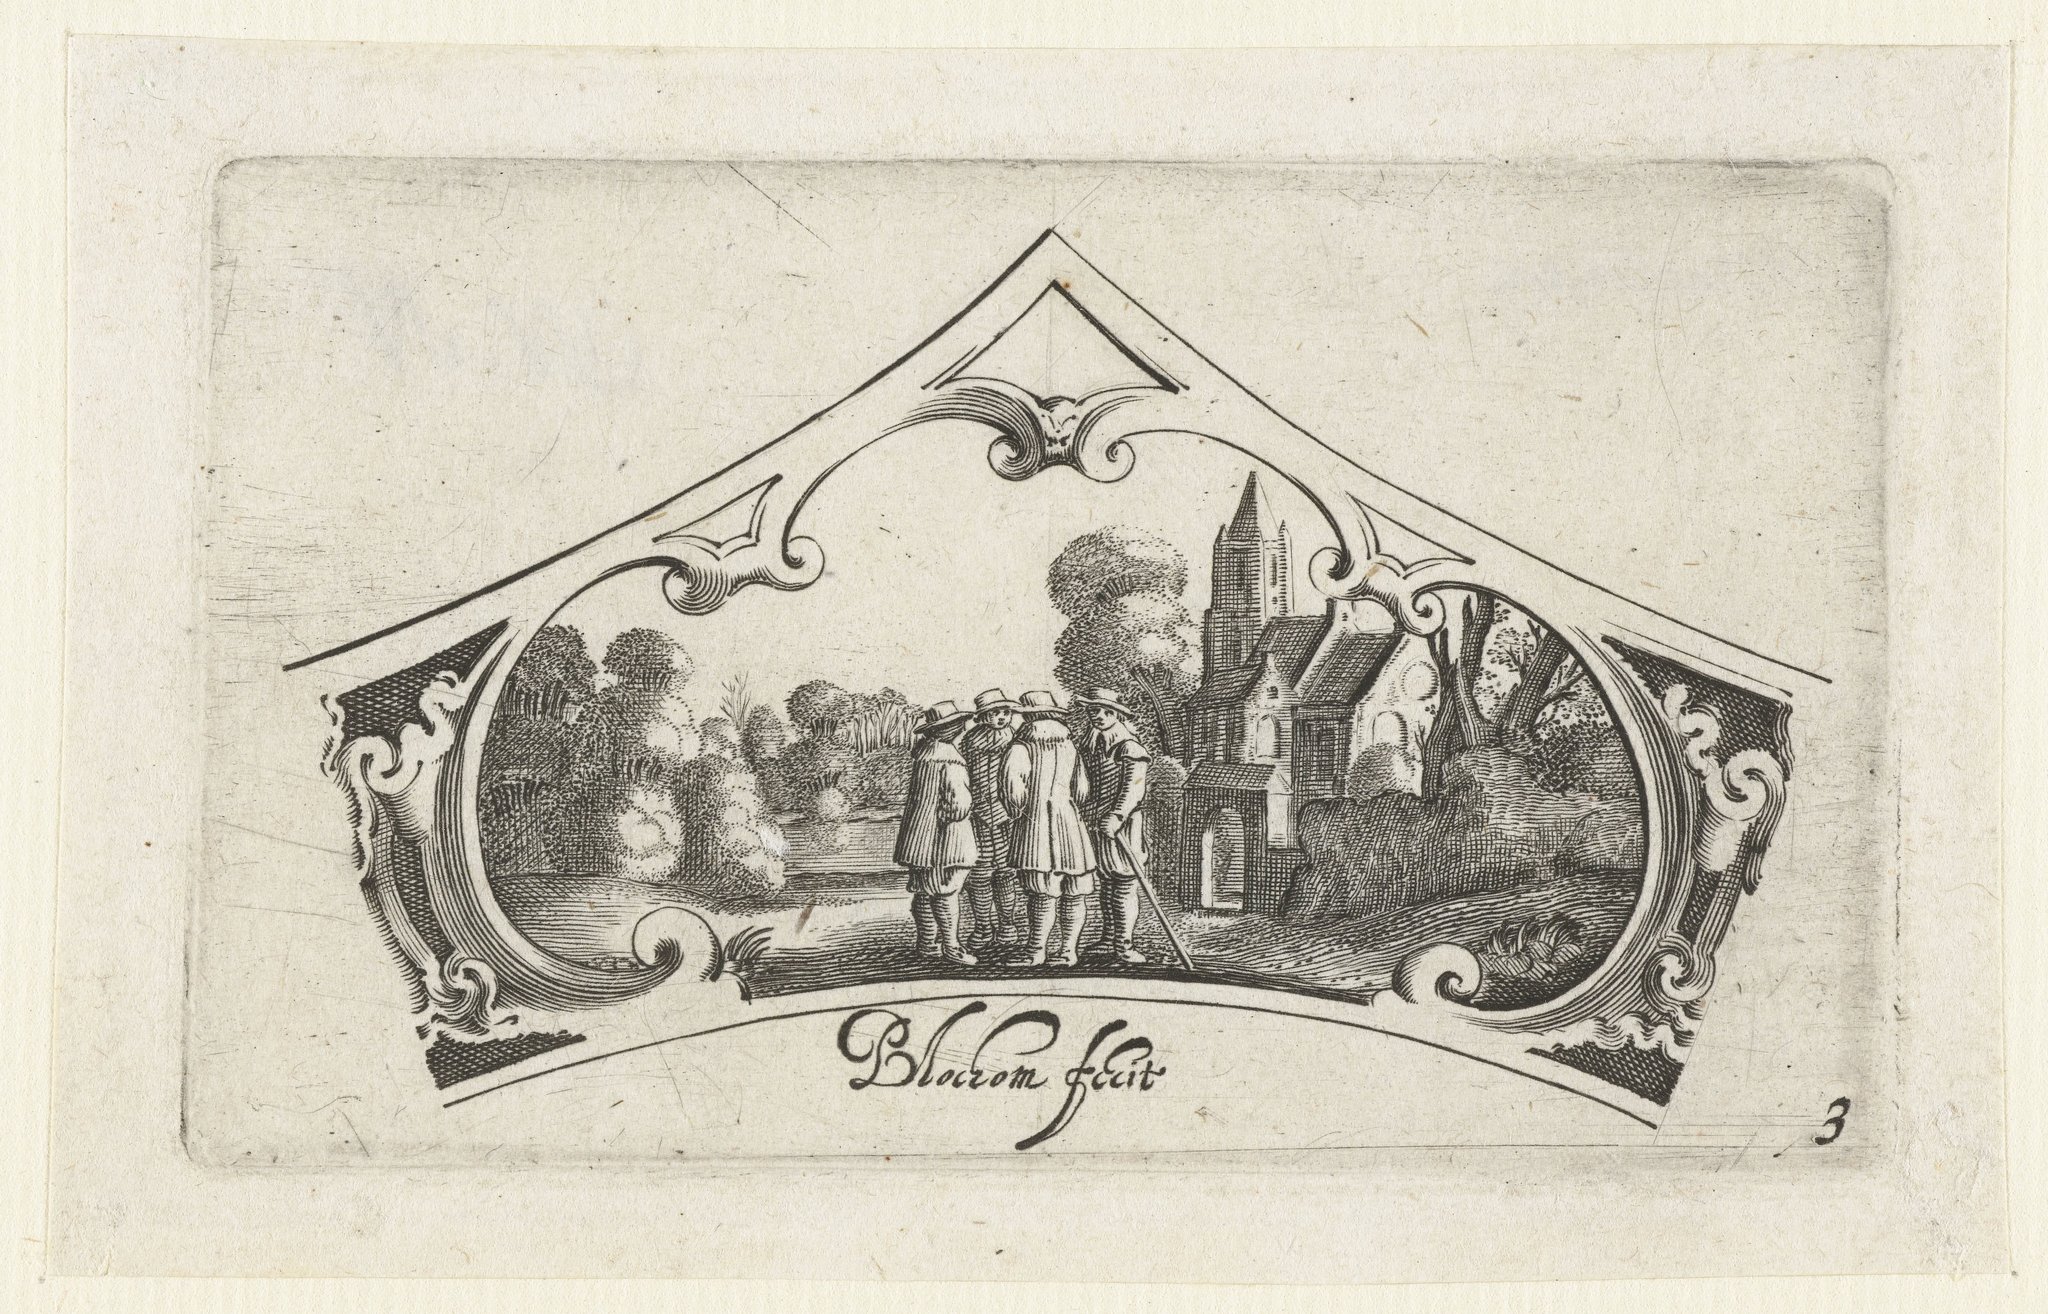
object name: ornament print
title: Vier pratende mannen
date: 1630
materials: paper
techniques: engraving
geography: amsterdam